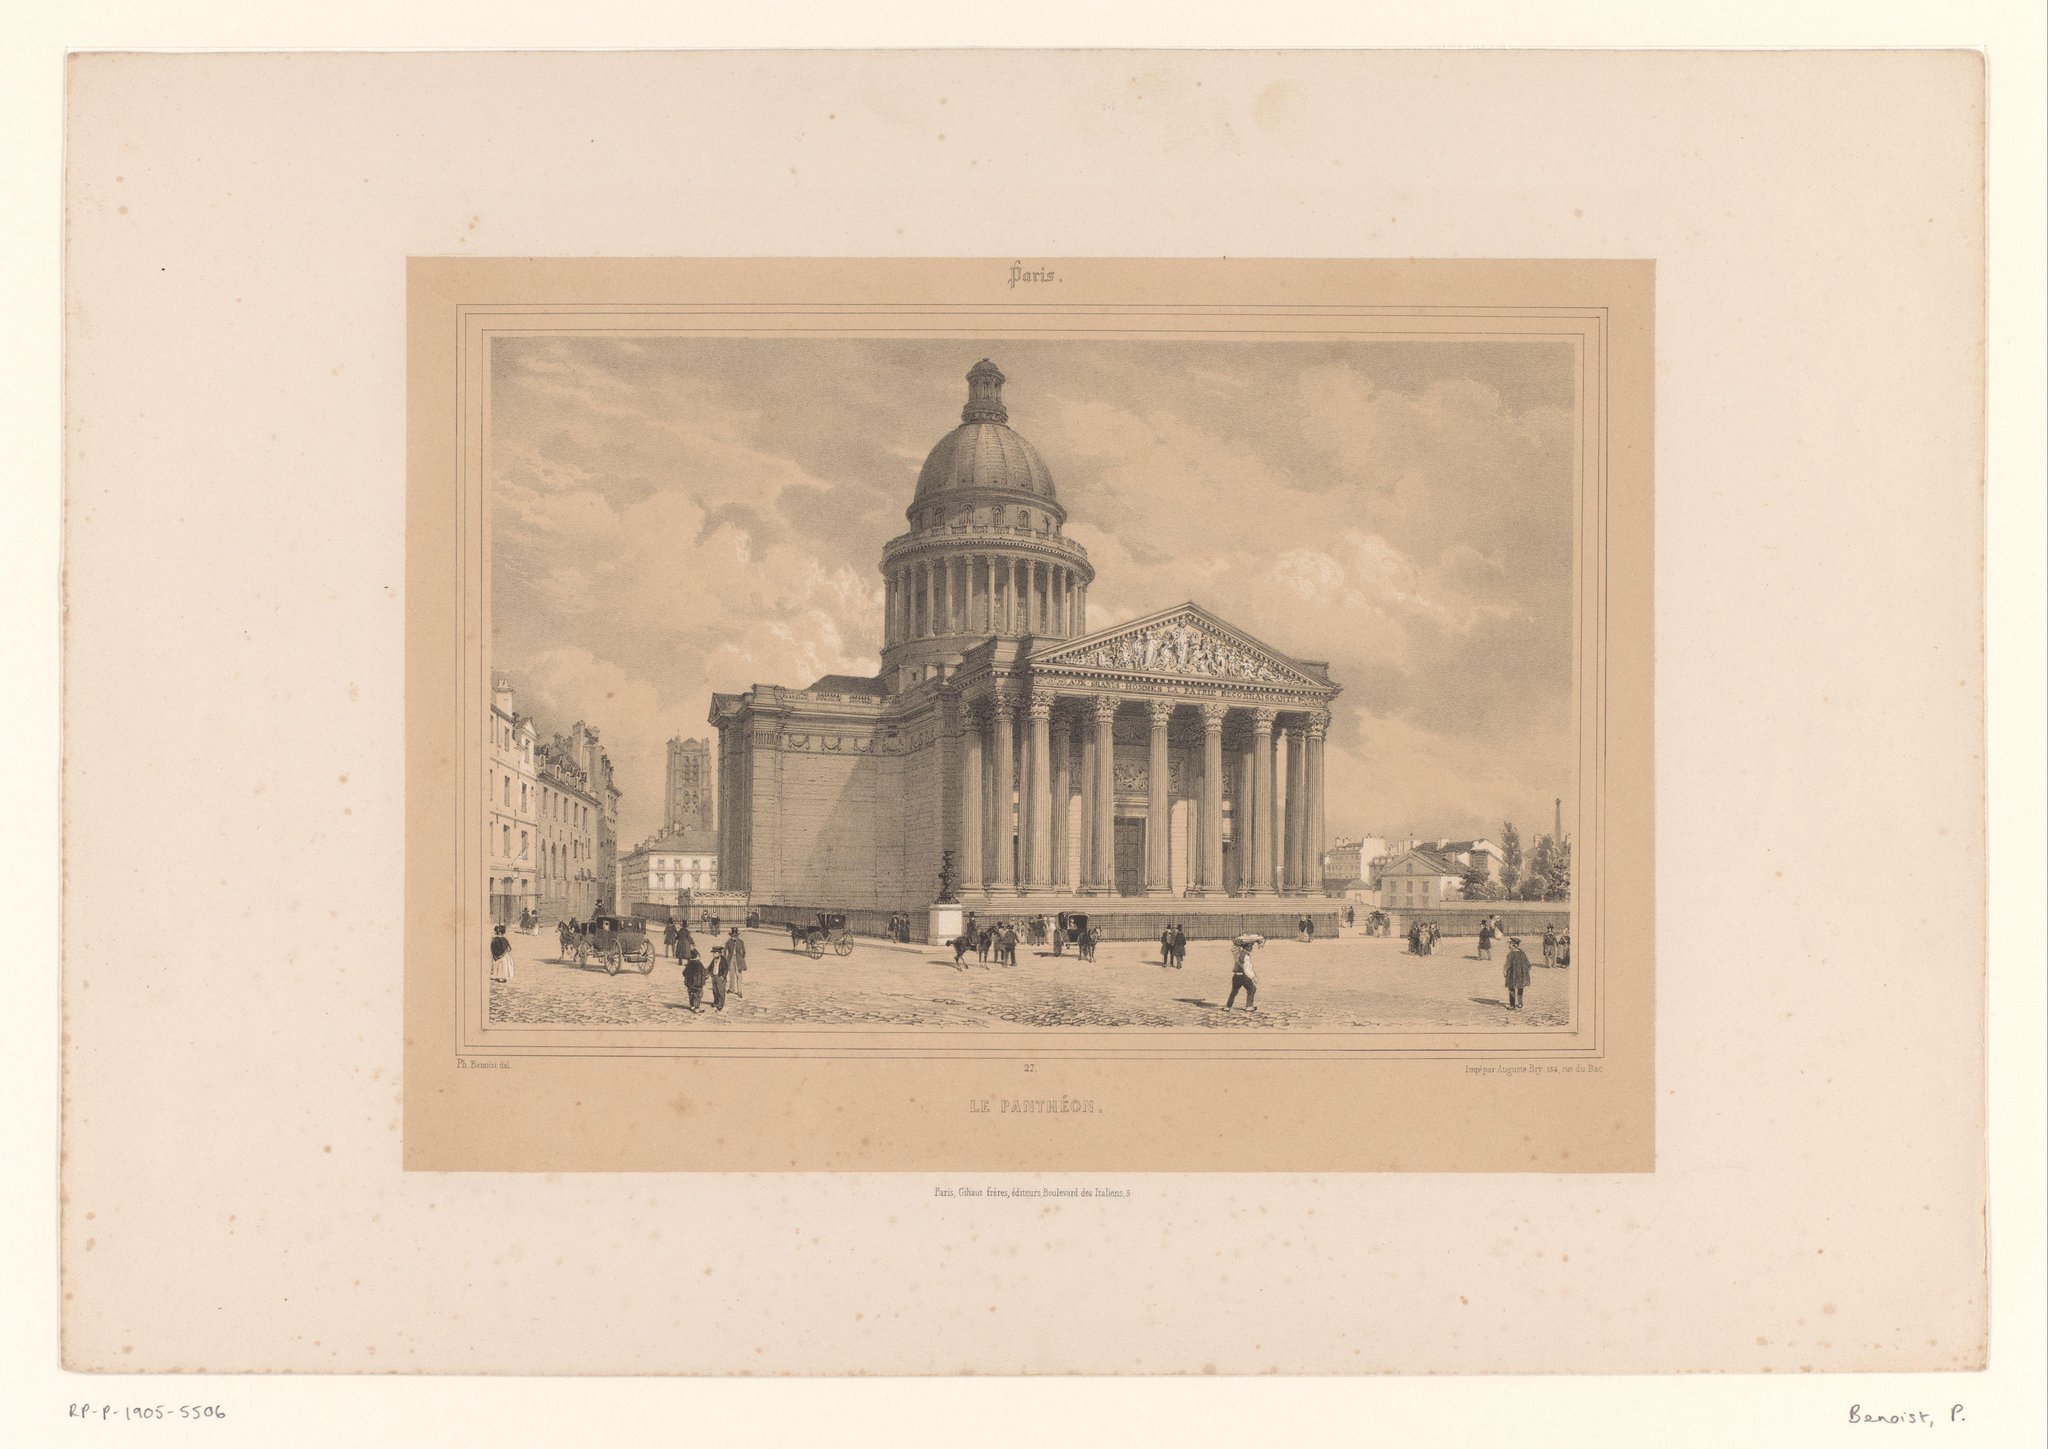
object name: print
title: Le Panthéon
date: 1843-1844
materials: paper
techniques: tone lithography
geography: paris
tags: church (exterior)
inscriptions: collector's mark: Lugt 2228a